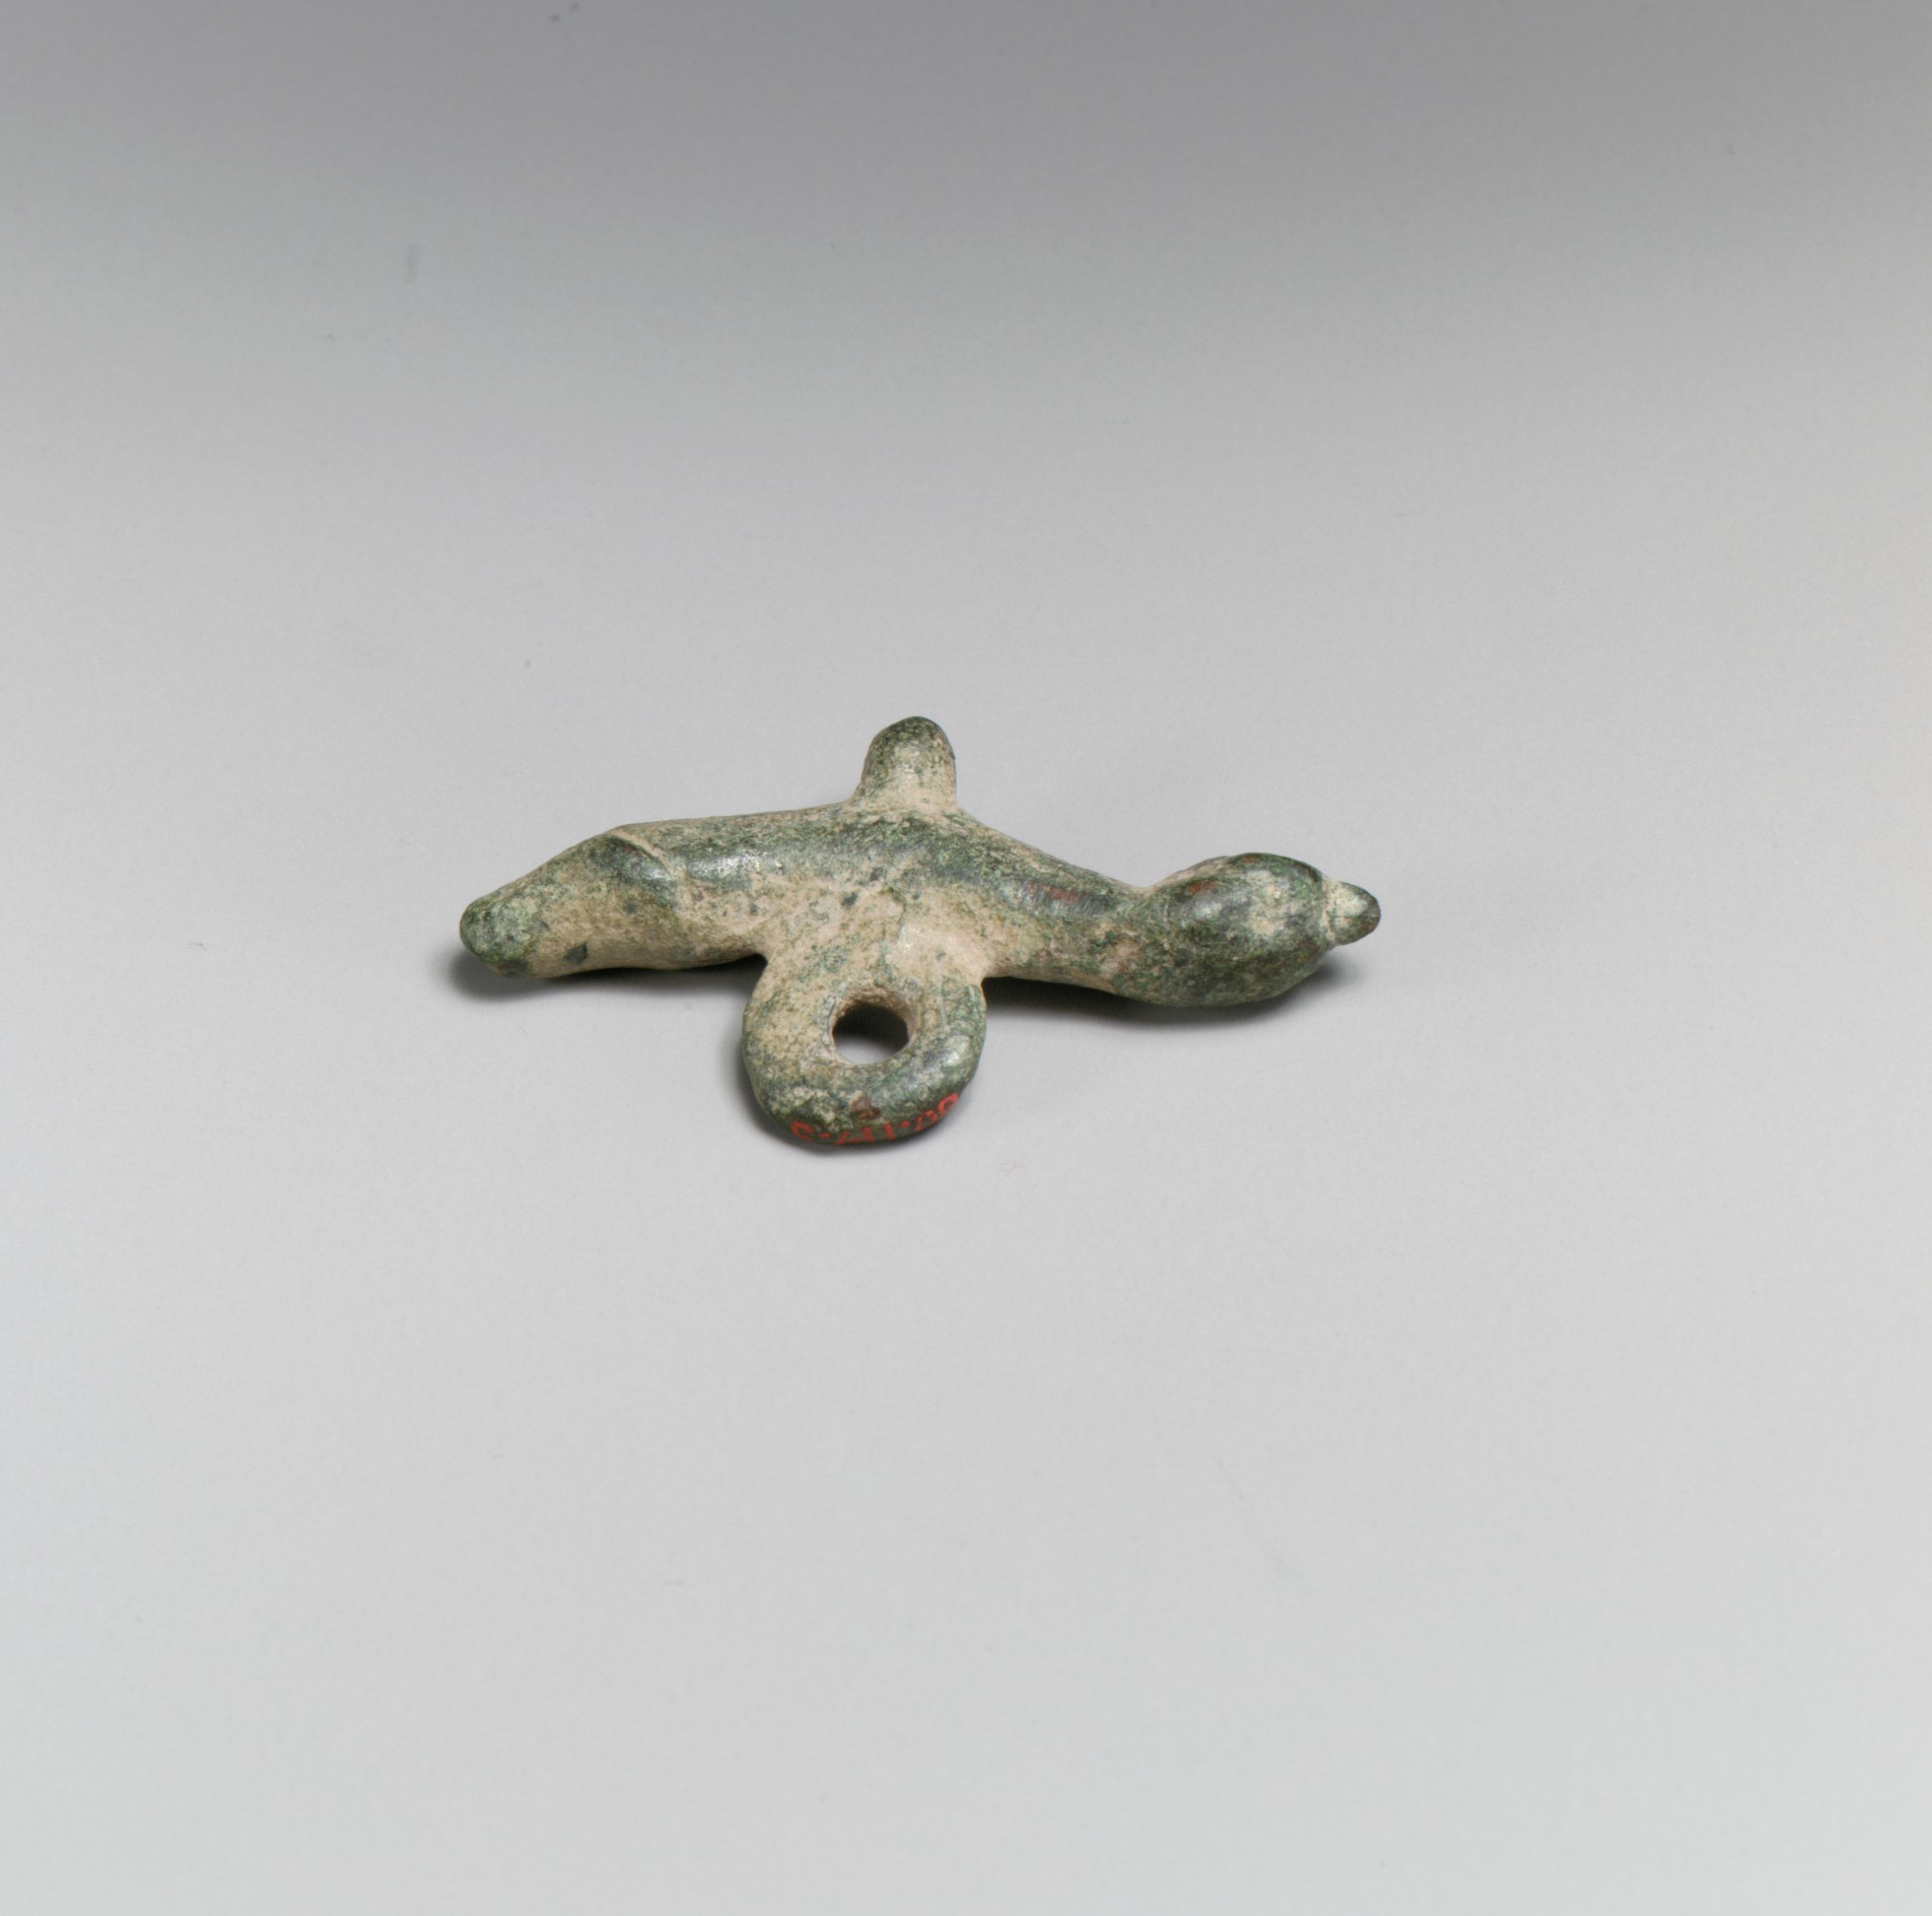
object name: amulet, grotesque ornament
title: Bronze phallic amulet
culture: roman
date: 1-100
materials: bronze